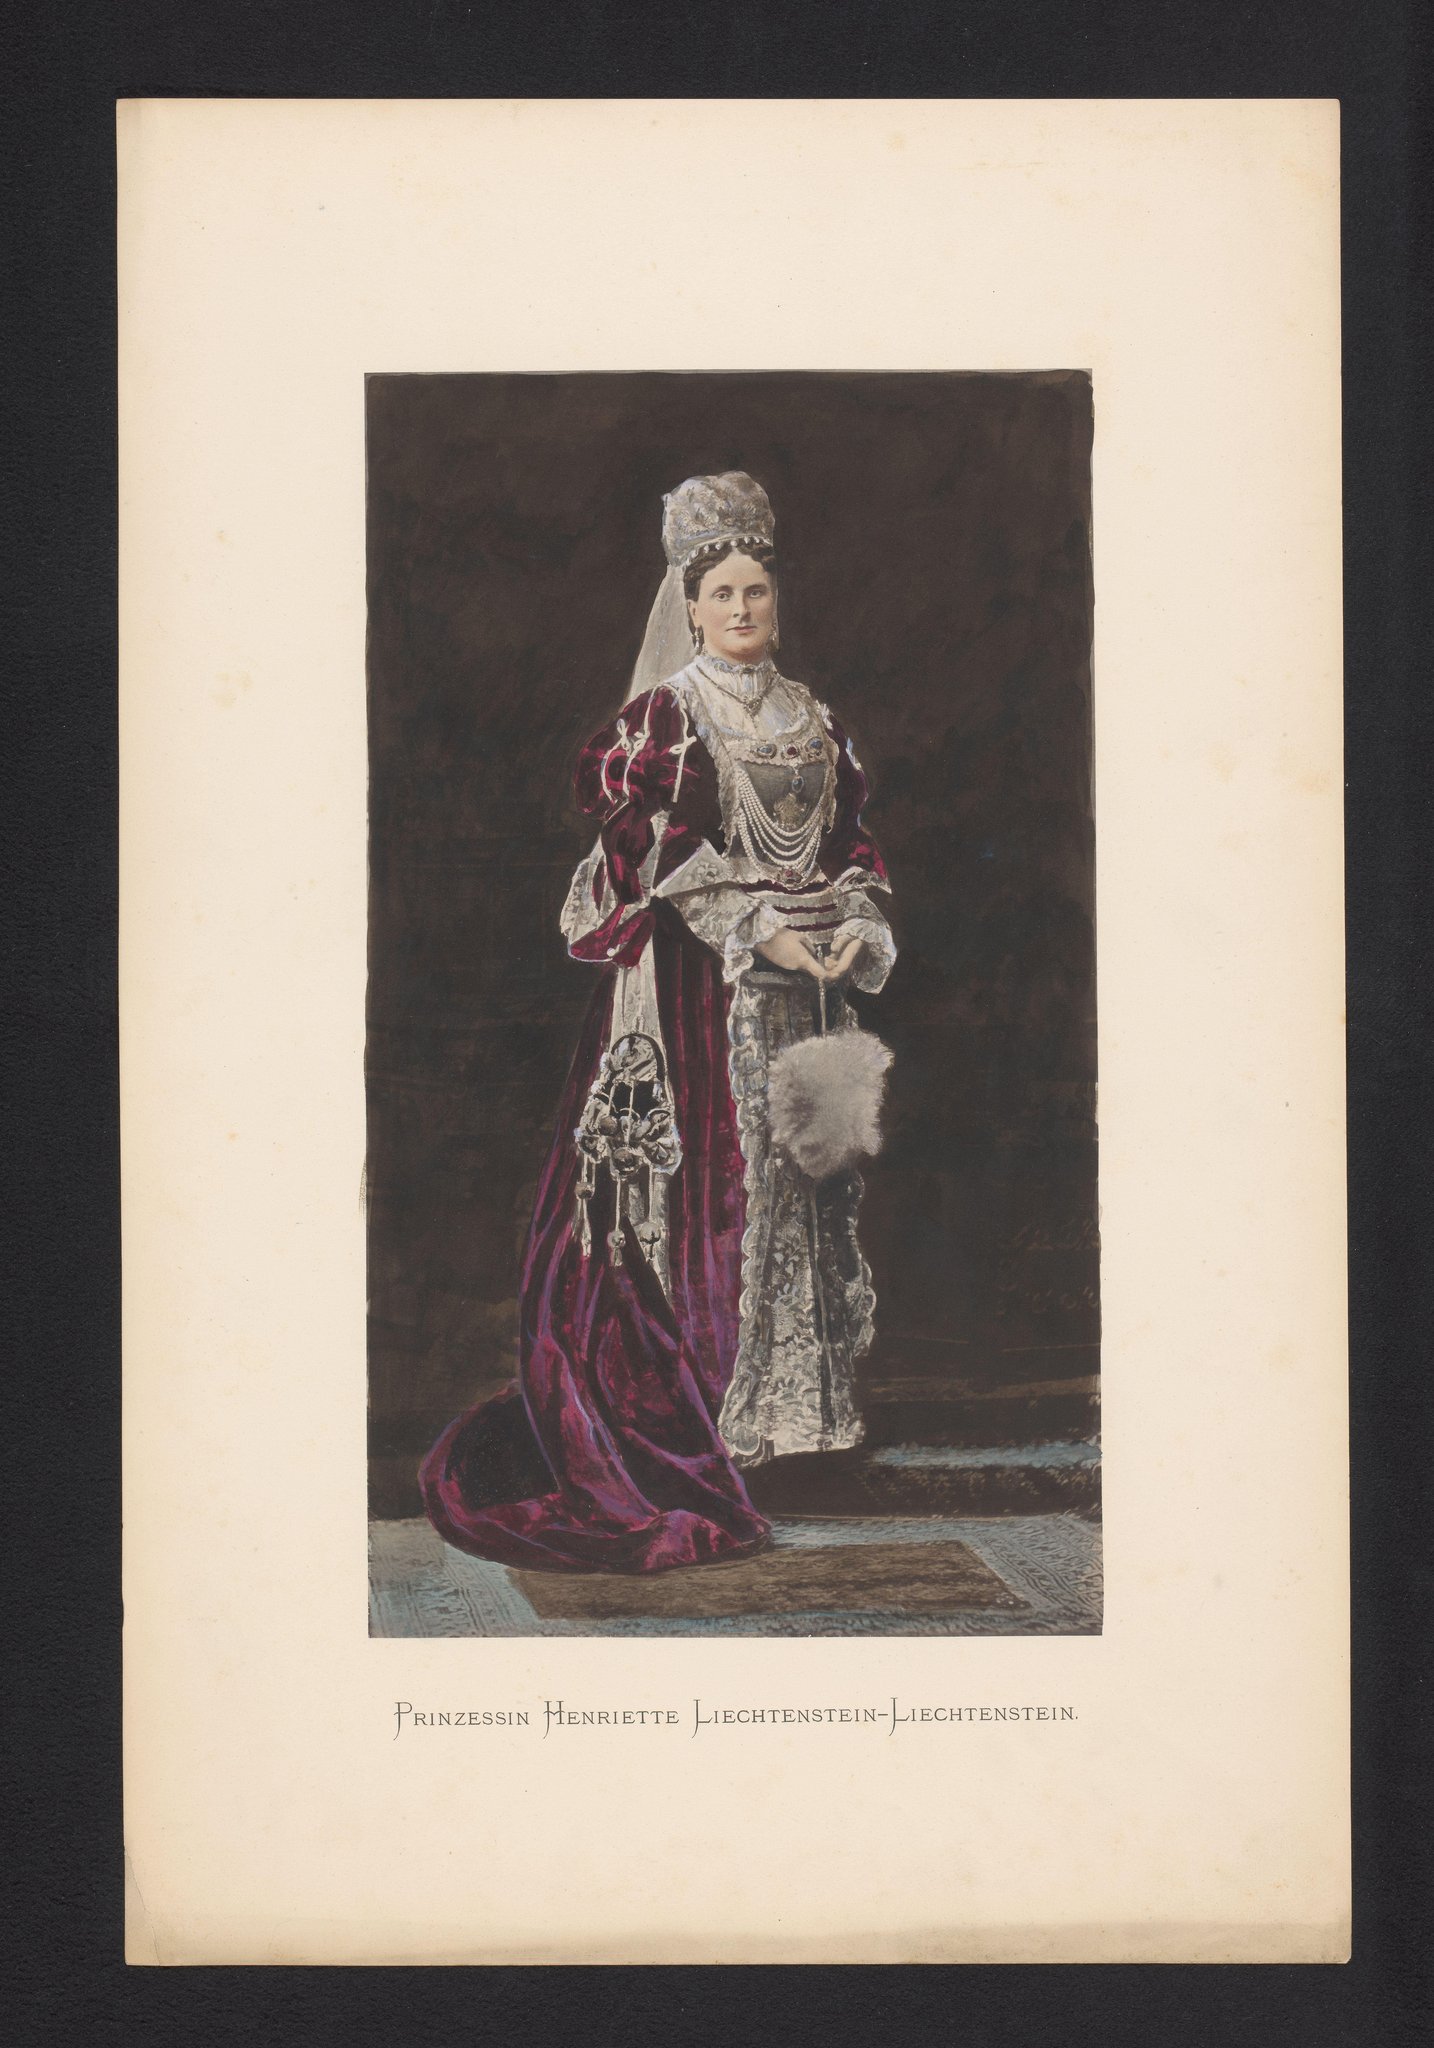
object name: photomechanical print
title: Prinzessin Henriette Liechtenstein-Liechtenstein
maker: Anonymous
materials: paper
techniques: photograph, hand coloring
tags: historical persons - bb - woman, princess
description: Deze prent maakt deel uit van een omslag met 86 prenten op 78 bladen en 11 tekstbladen.